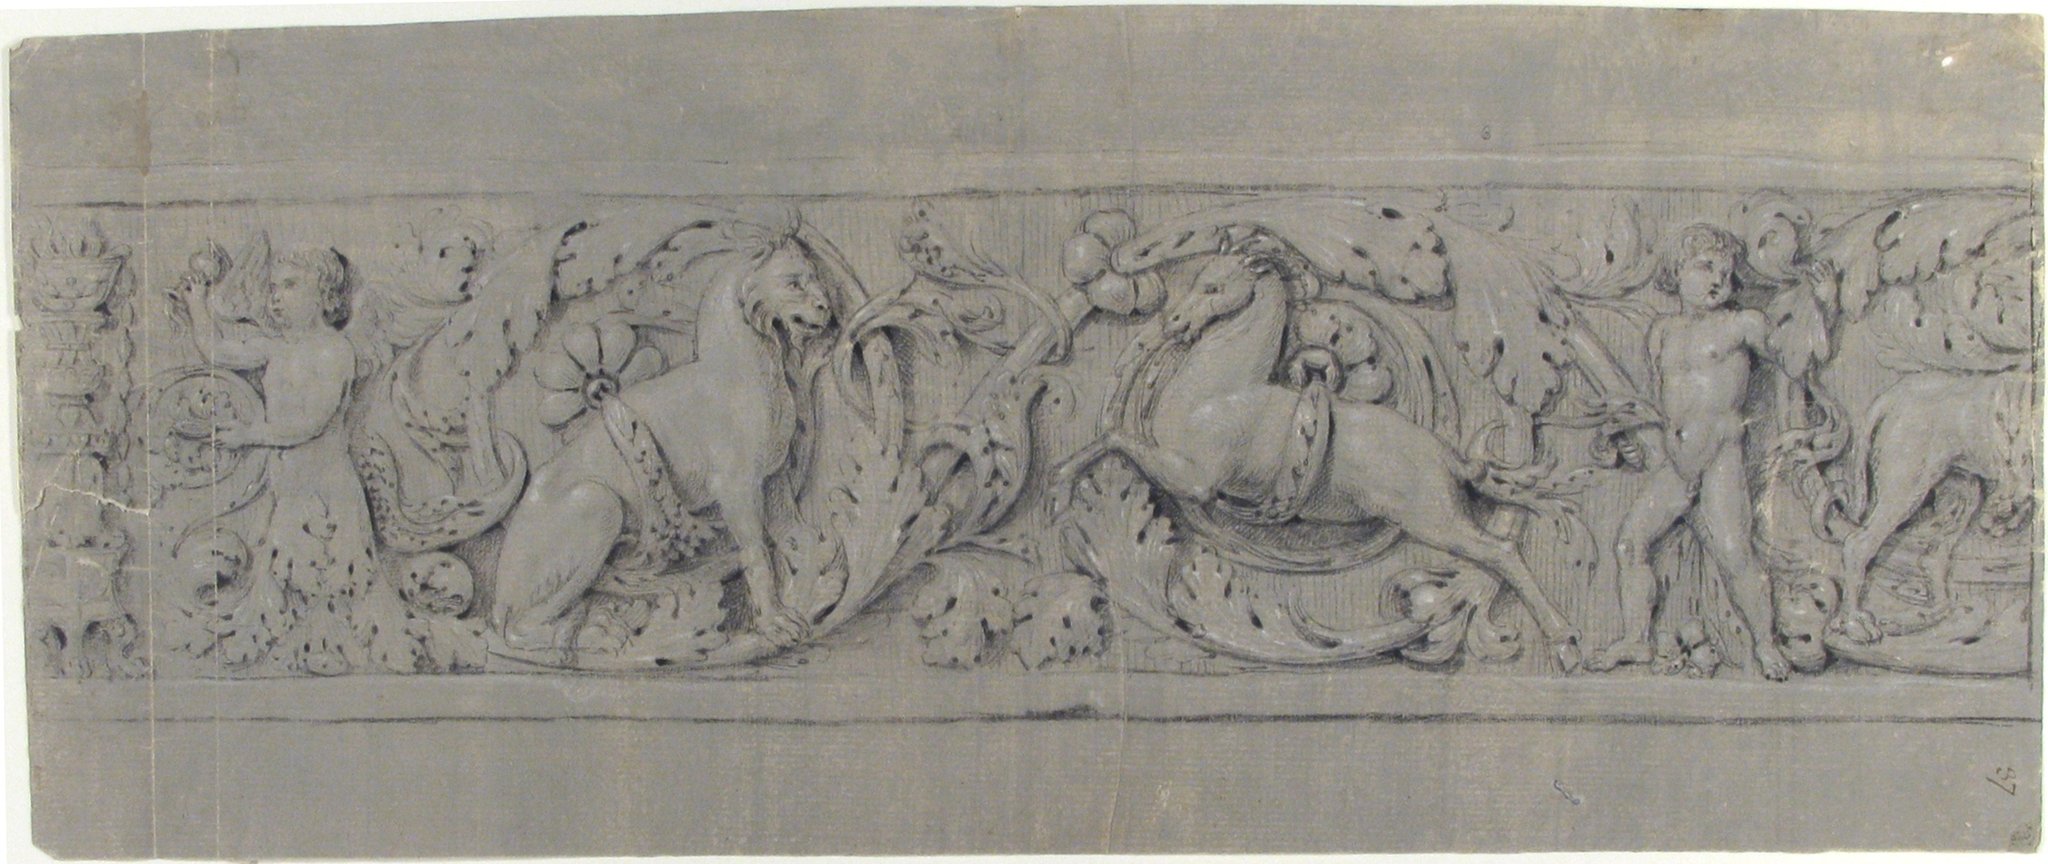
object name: drawing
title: Design for a Decorative Frieze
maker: anonymous, french, 19th century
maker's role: artist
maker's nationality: french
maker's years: 1800-1900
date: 1825-1850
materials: chalk, graphite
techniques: heightening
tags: ornament,horses,lions